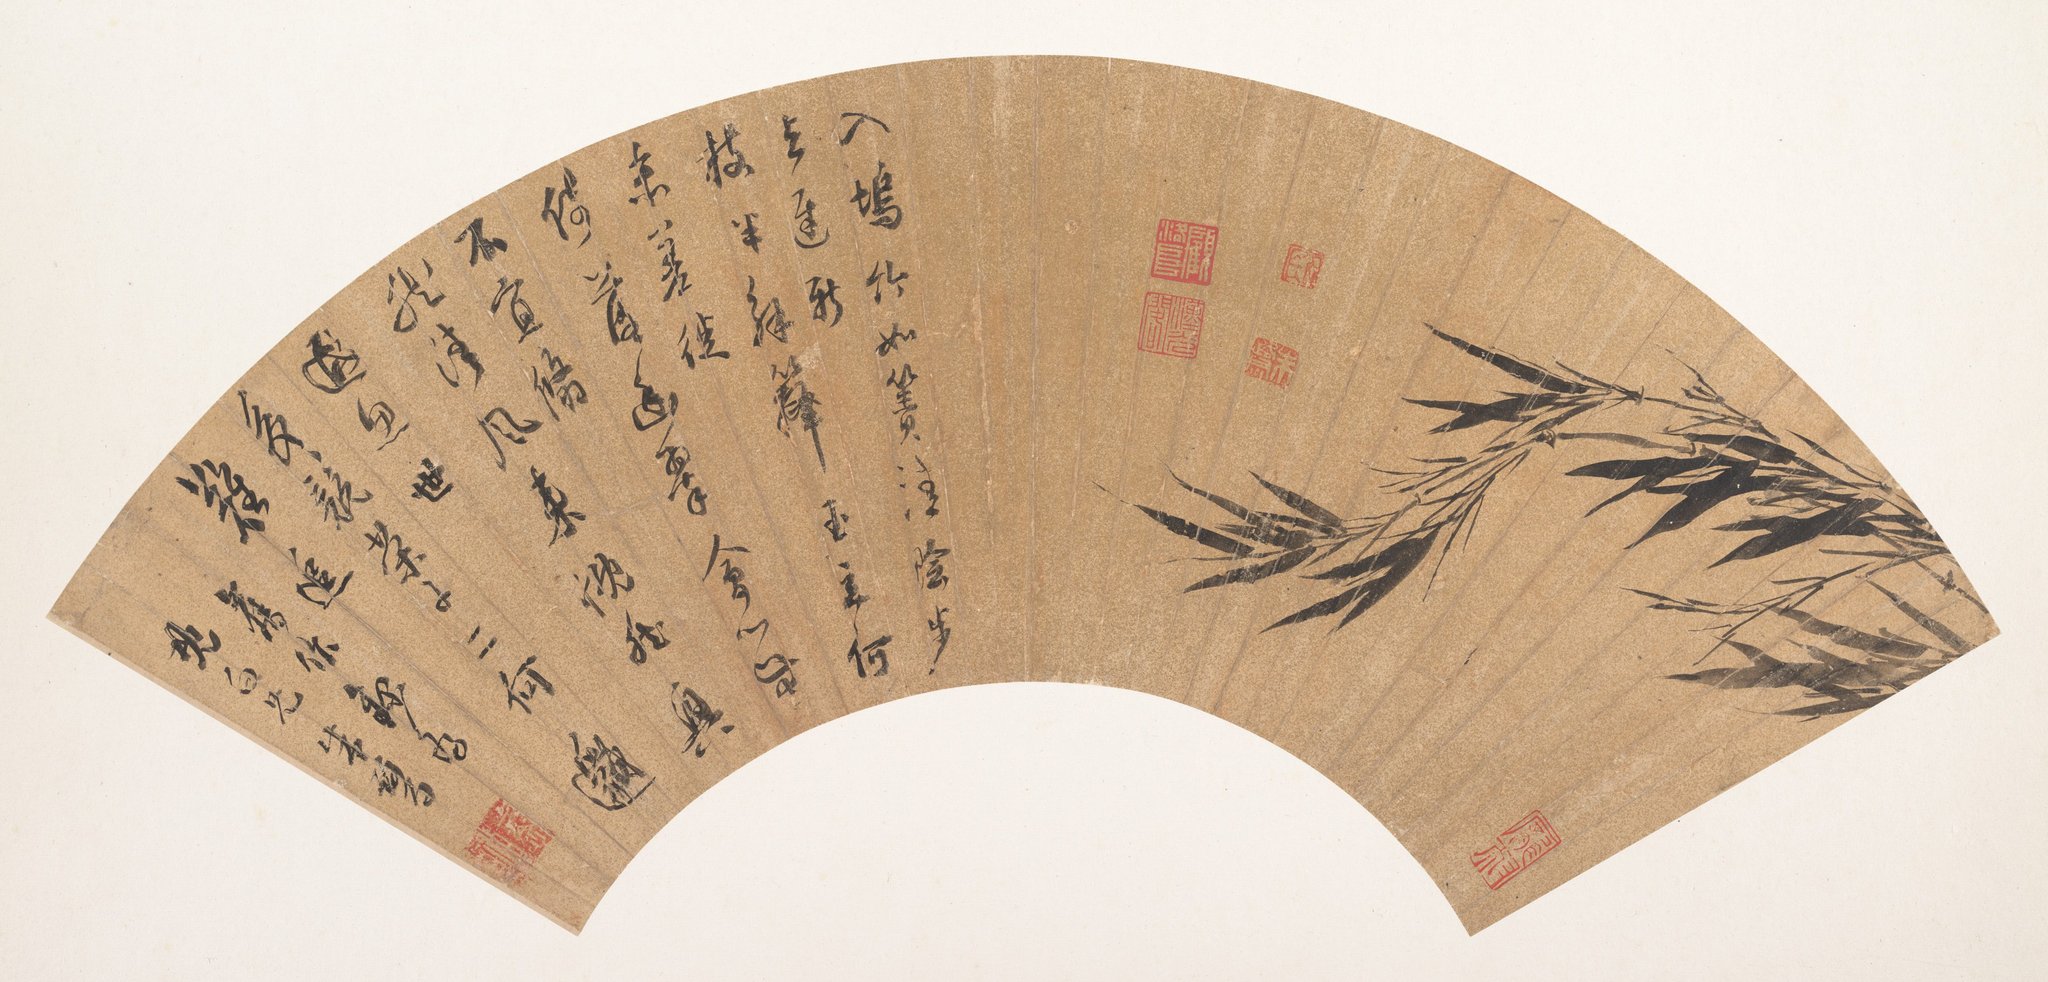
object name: folding fan mounted a an album leaf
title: Bamboo and poem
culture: chinese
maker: zhu lu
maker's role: artist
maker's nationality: chinese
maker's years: 1553-1632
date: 1601-1633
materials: gold, ink, paper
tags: poetry,bamboo